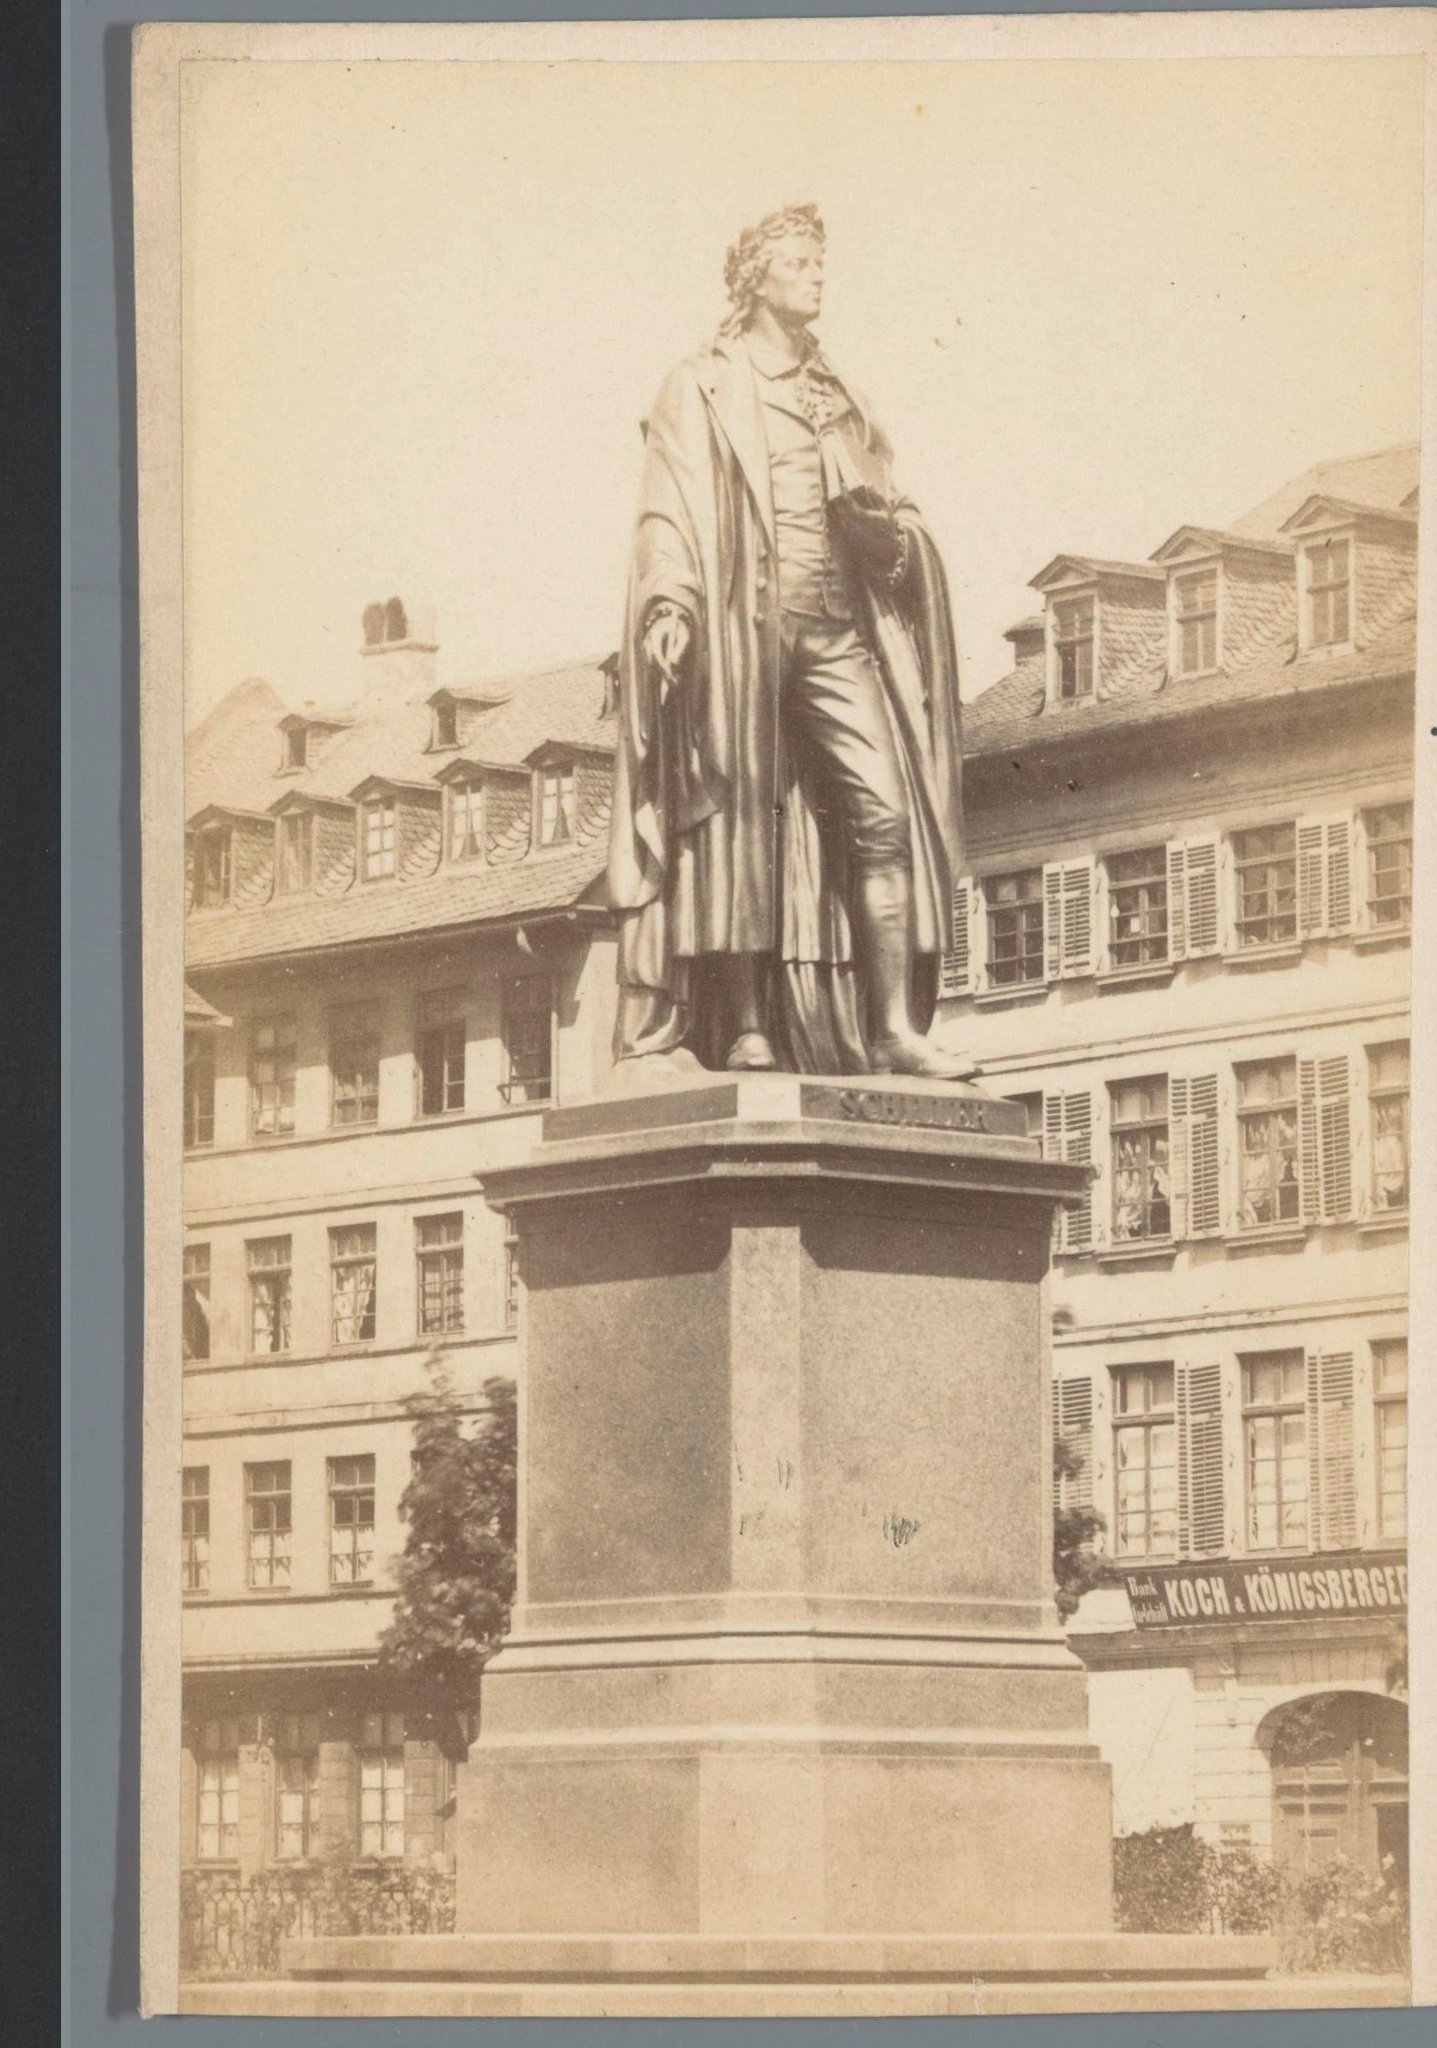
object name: carte de visite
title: Standbeeld van Schiller in Frankfurt am Main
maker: Anonymous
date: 1860-1875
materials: cardboard, paper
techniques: albumen print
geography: frankfurt am main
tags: monument, statue